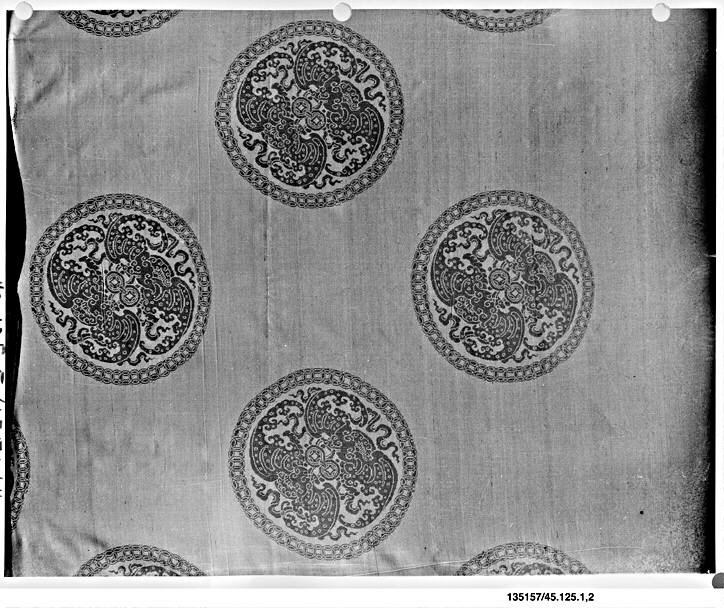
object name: piece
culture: chinese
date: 1801-1900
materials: silk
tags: bats